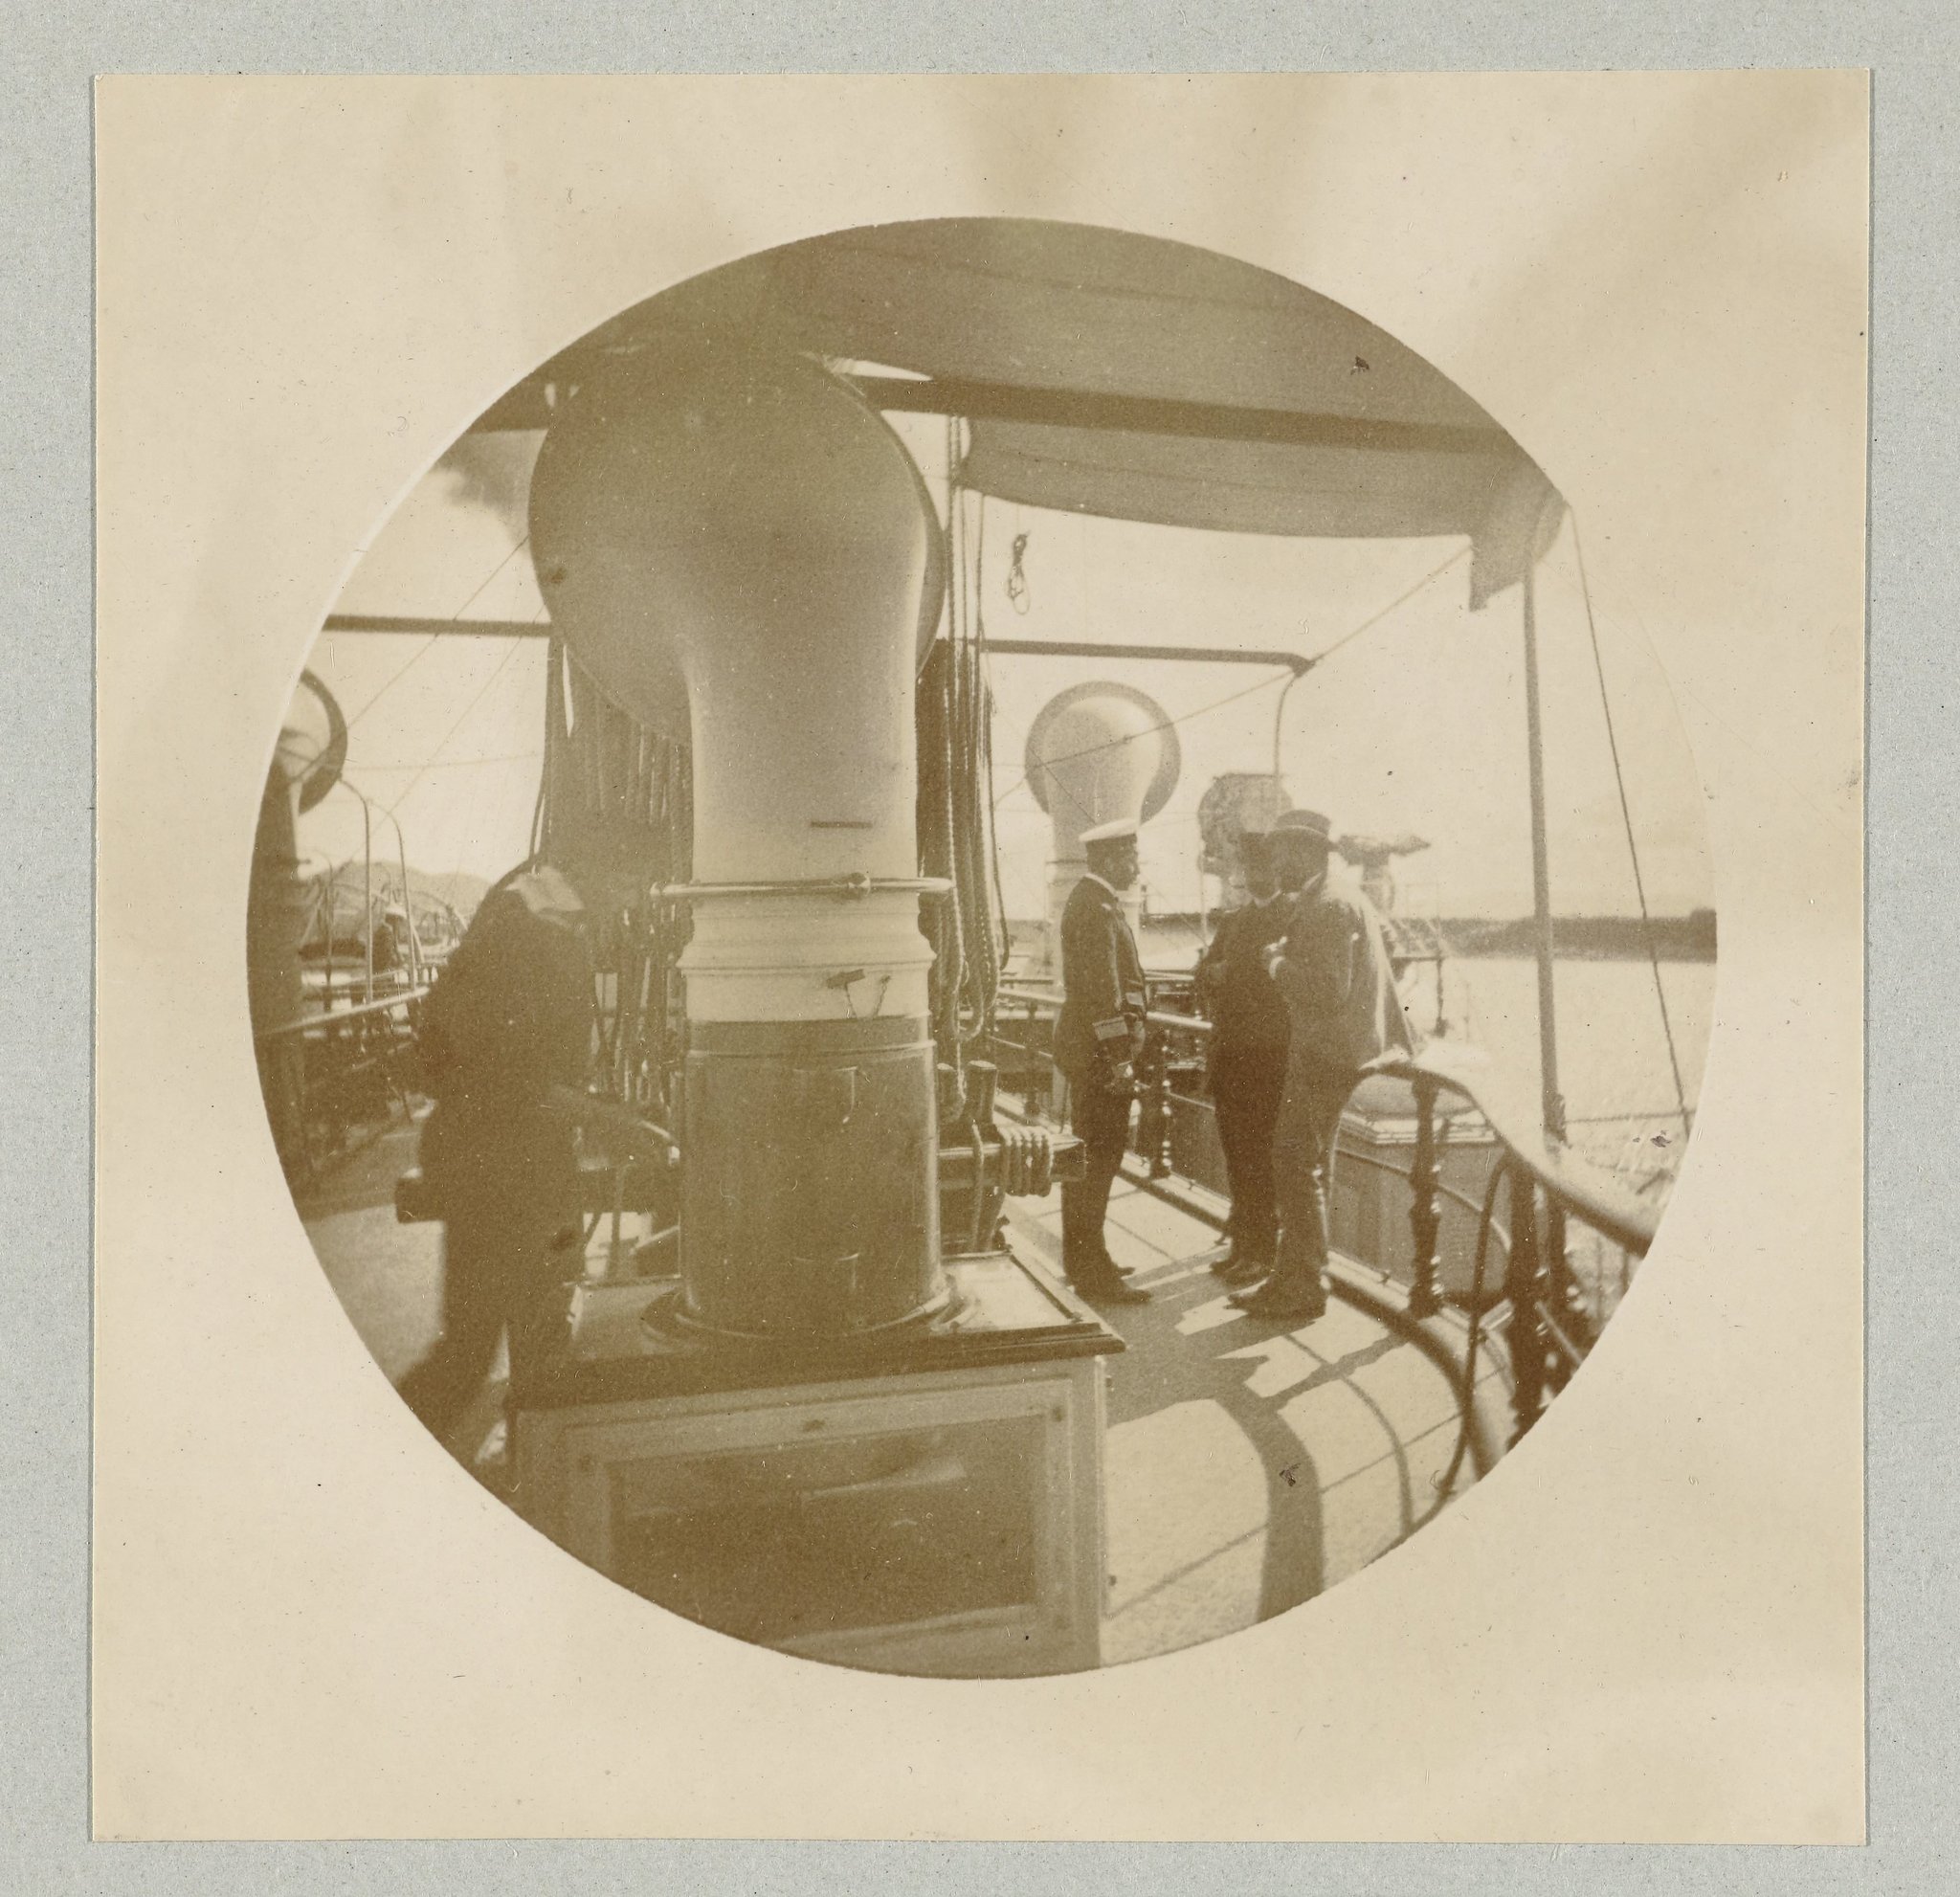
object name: photograph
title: Reisgenoten van Keizer Wilhelm II aan boord van de Hohenzollern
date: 1807-1889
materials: cardboard, paper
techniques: gelatin silver print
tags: wilhelm ii (keizer van duitsland), norway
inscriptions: number: ‘1a’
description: De foto is rond maar is afgedrukt op vierkant papier